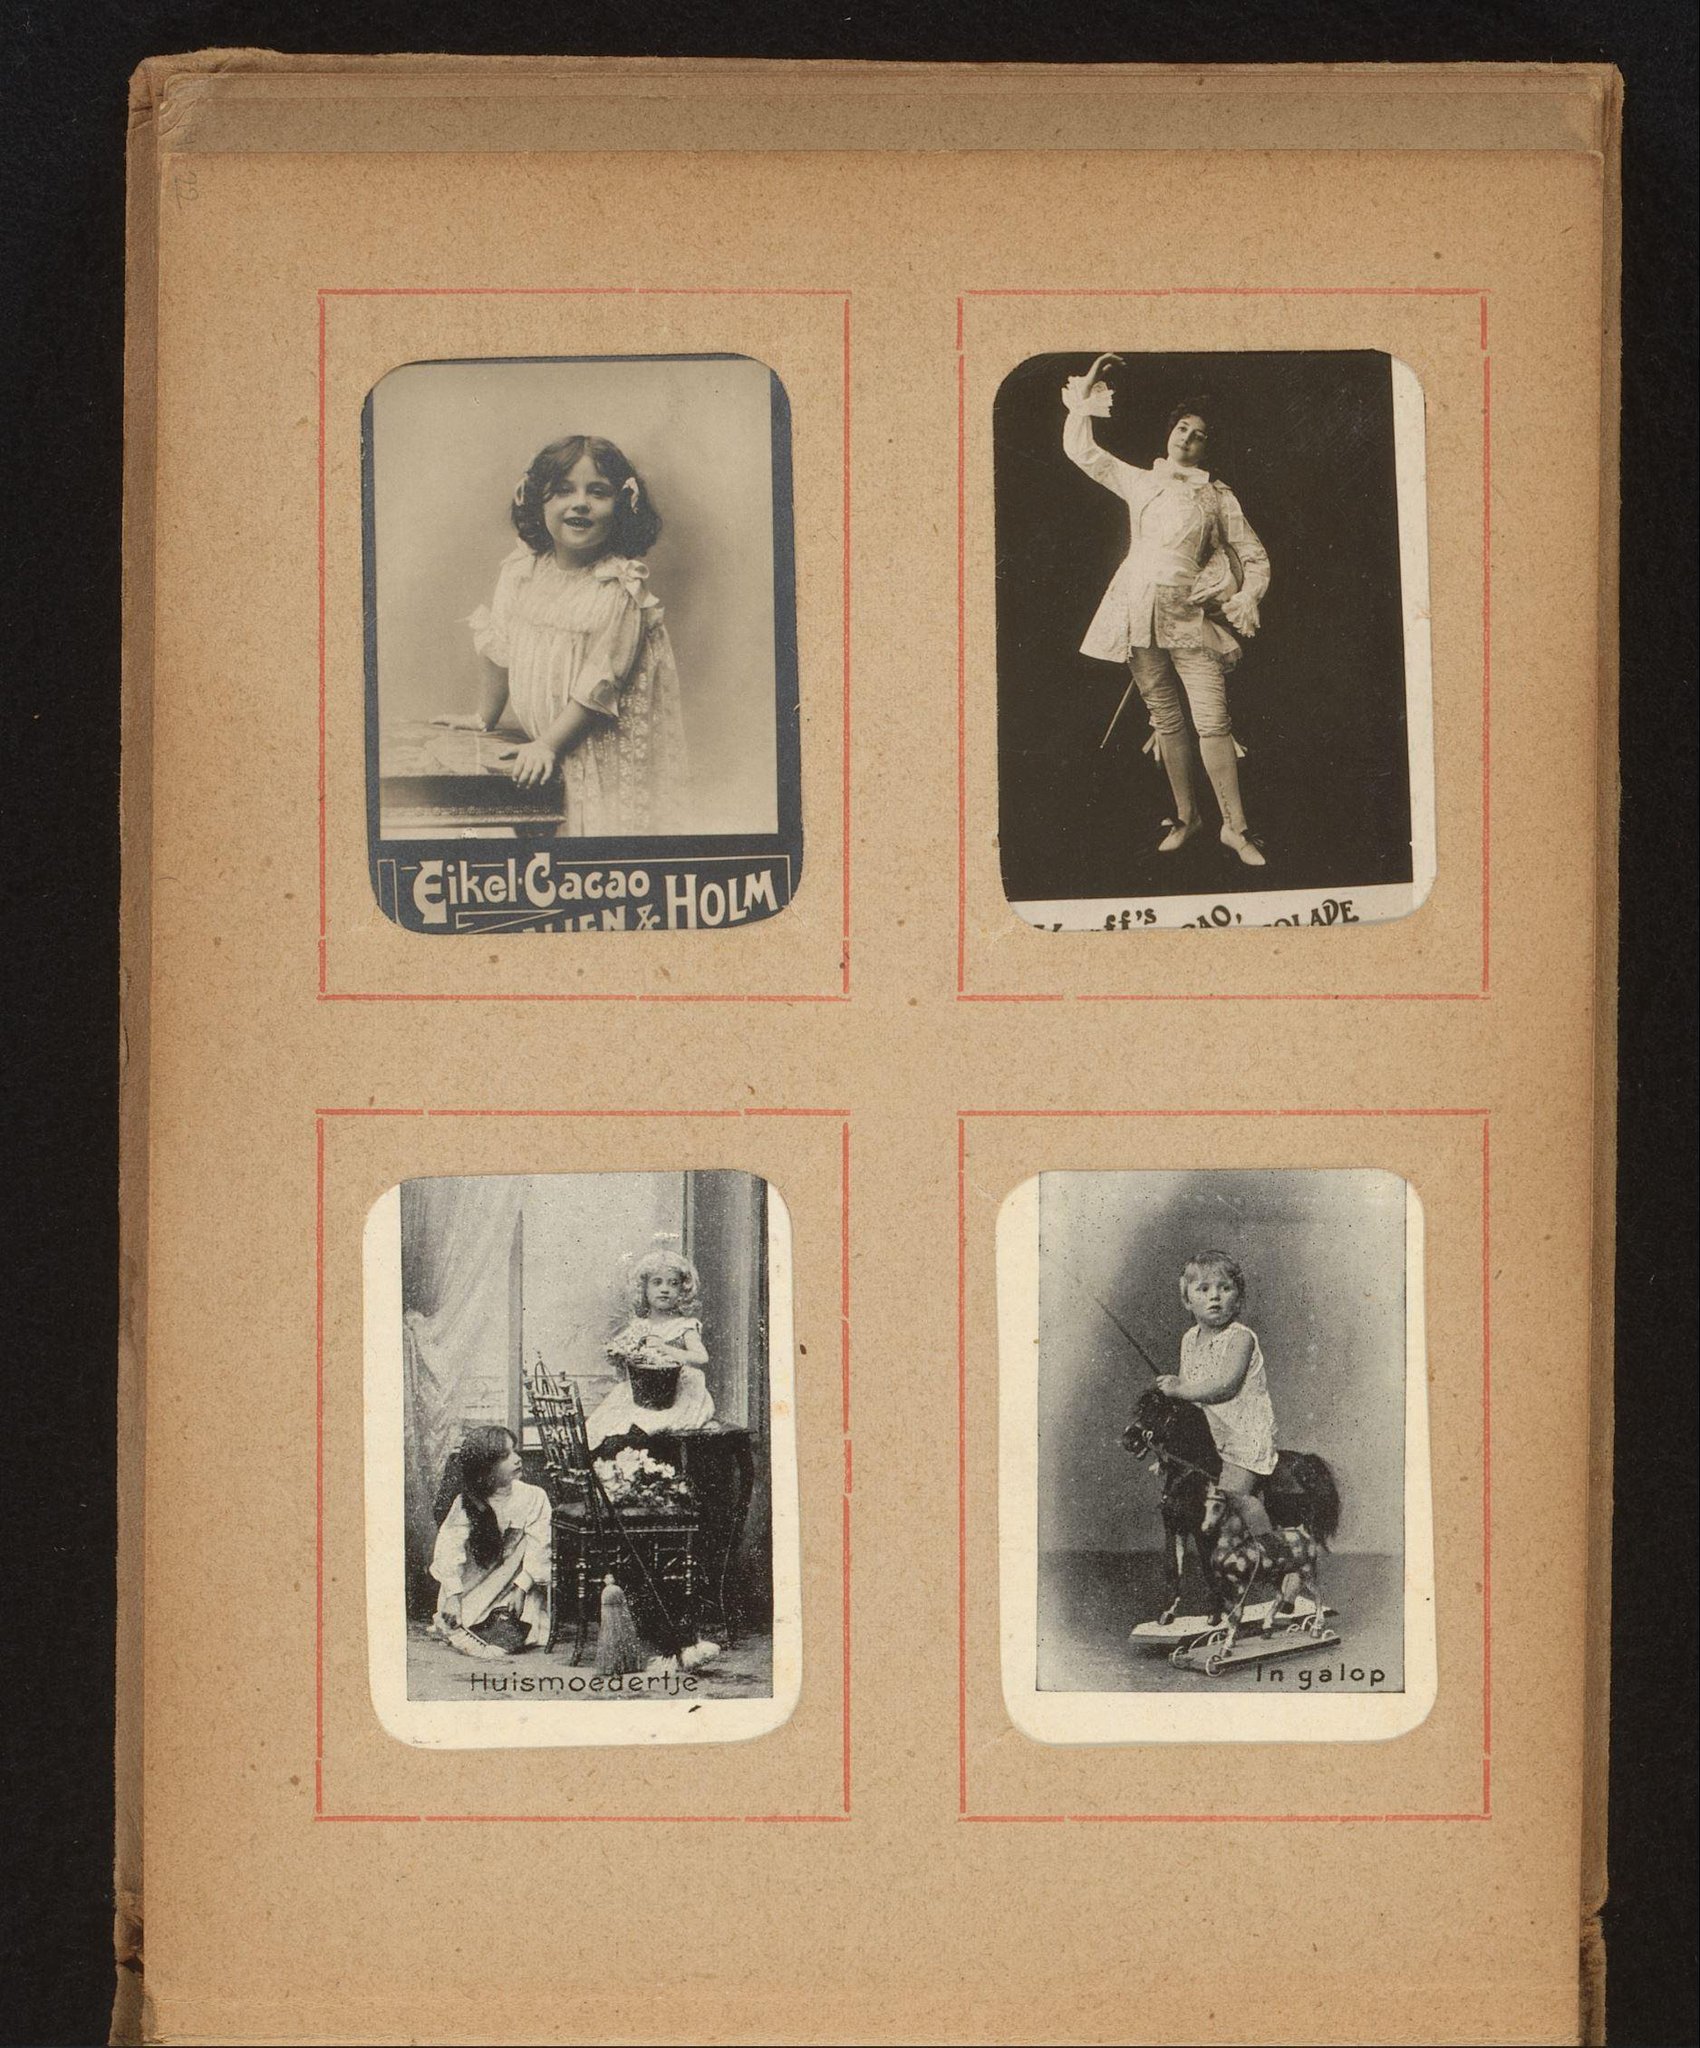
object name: photomechanical print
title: Portetten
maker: Anonymous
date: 1880-1920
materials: paper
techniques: autotype, gelatin silver print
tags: adolescent, young woman, maiden, child, rocking-horse, trade games, imitative games, imitating adults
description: Drie kinderportretten en een portret van een jonge vrouw. Op de voorzijde staan opschriften; Eikel Cacao, Huismoedertje en In galop. Deze pagina maakt deel uit van een album.